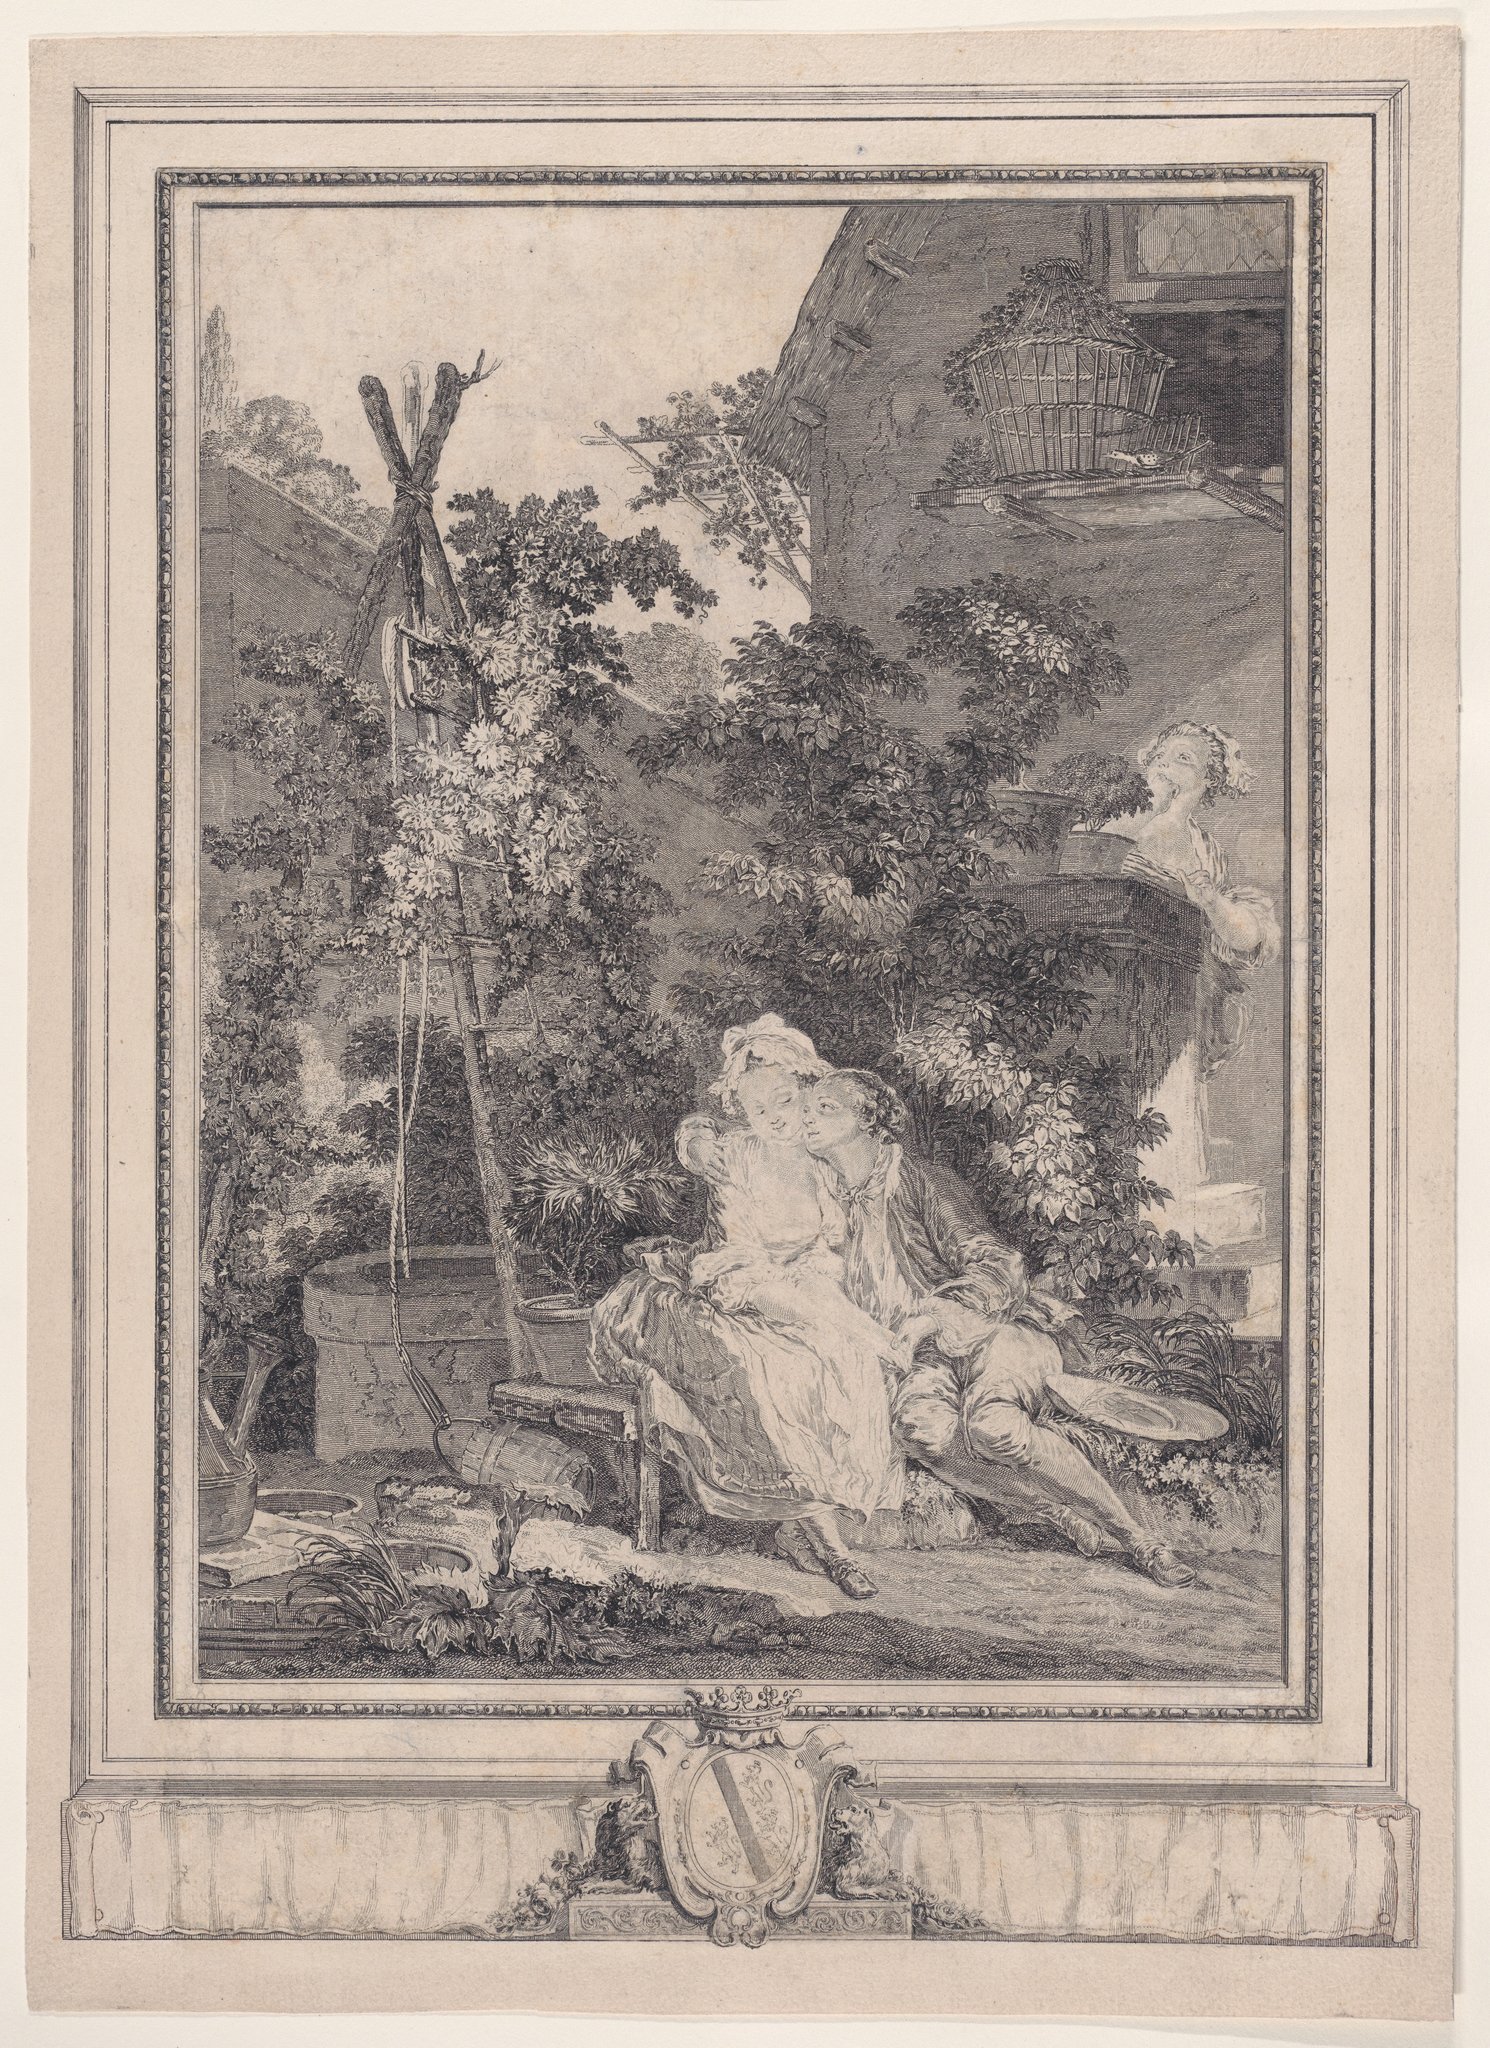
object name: print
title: Le Jardinier Galant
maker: pierre antoine baudouin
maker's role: artist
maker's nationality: french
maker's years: 1723-1769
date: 1778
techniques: engraving, etching